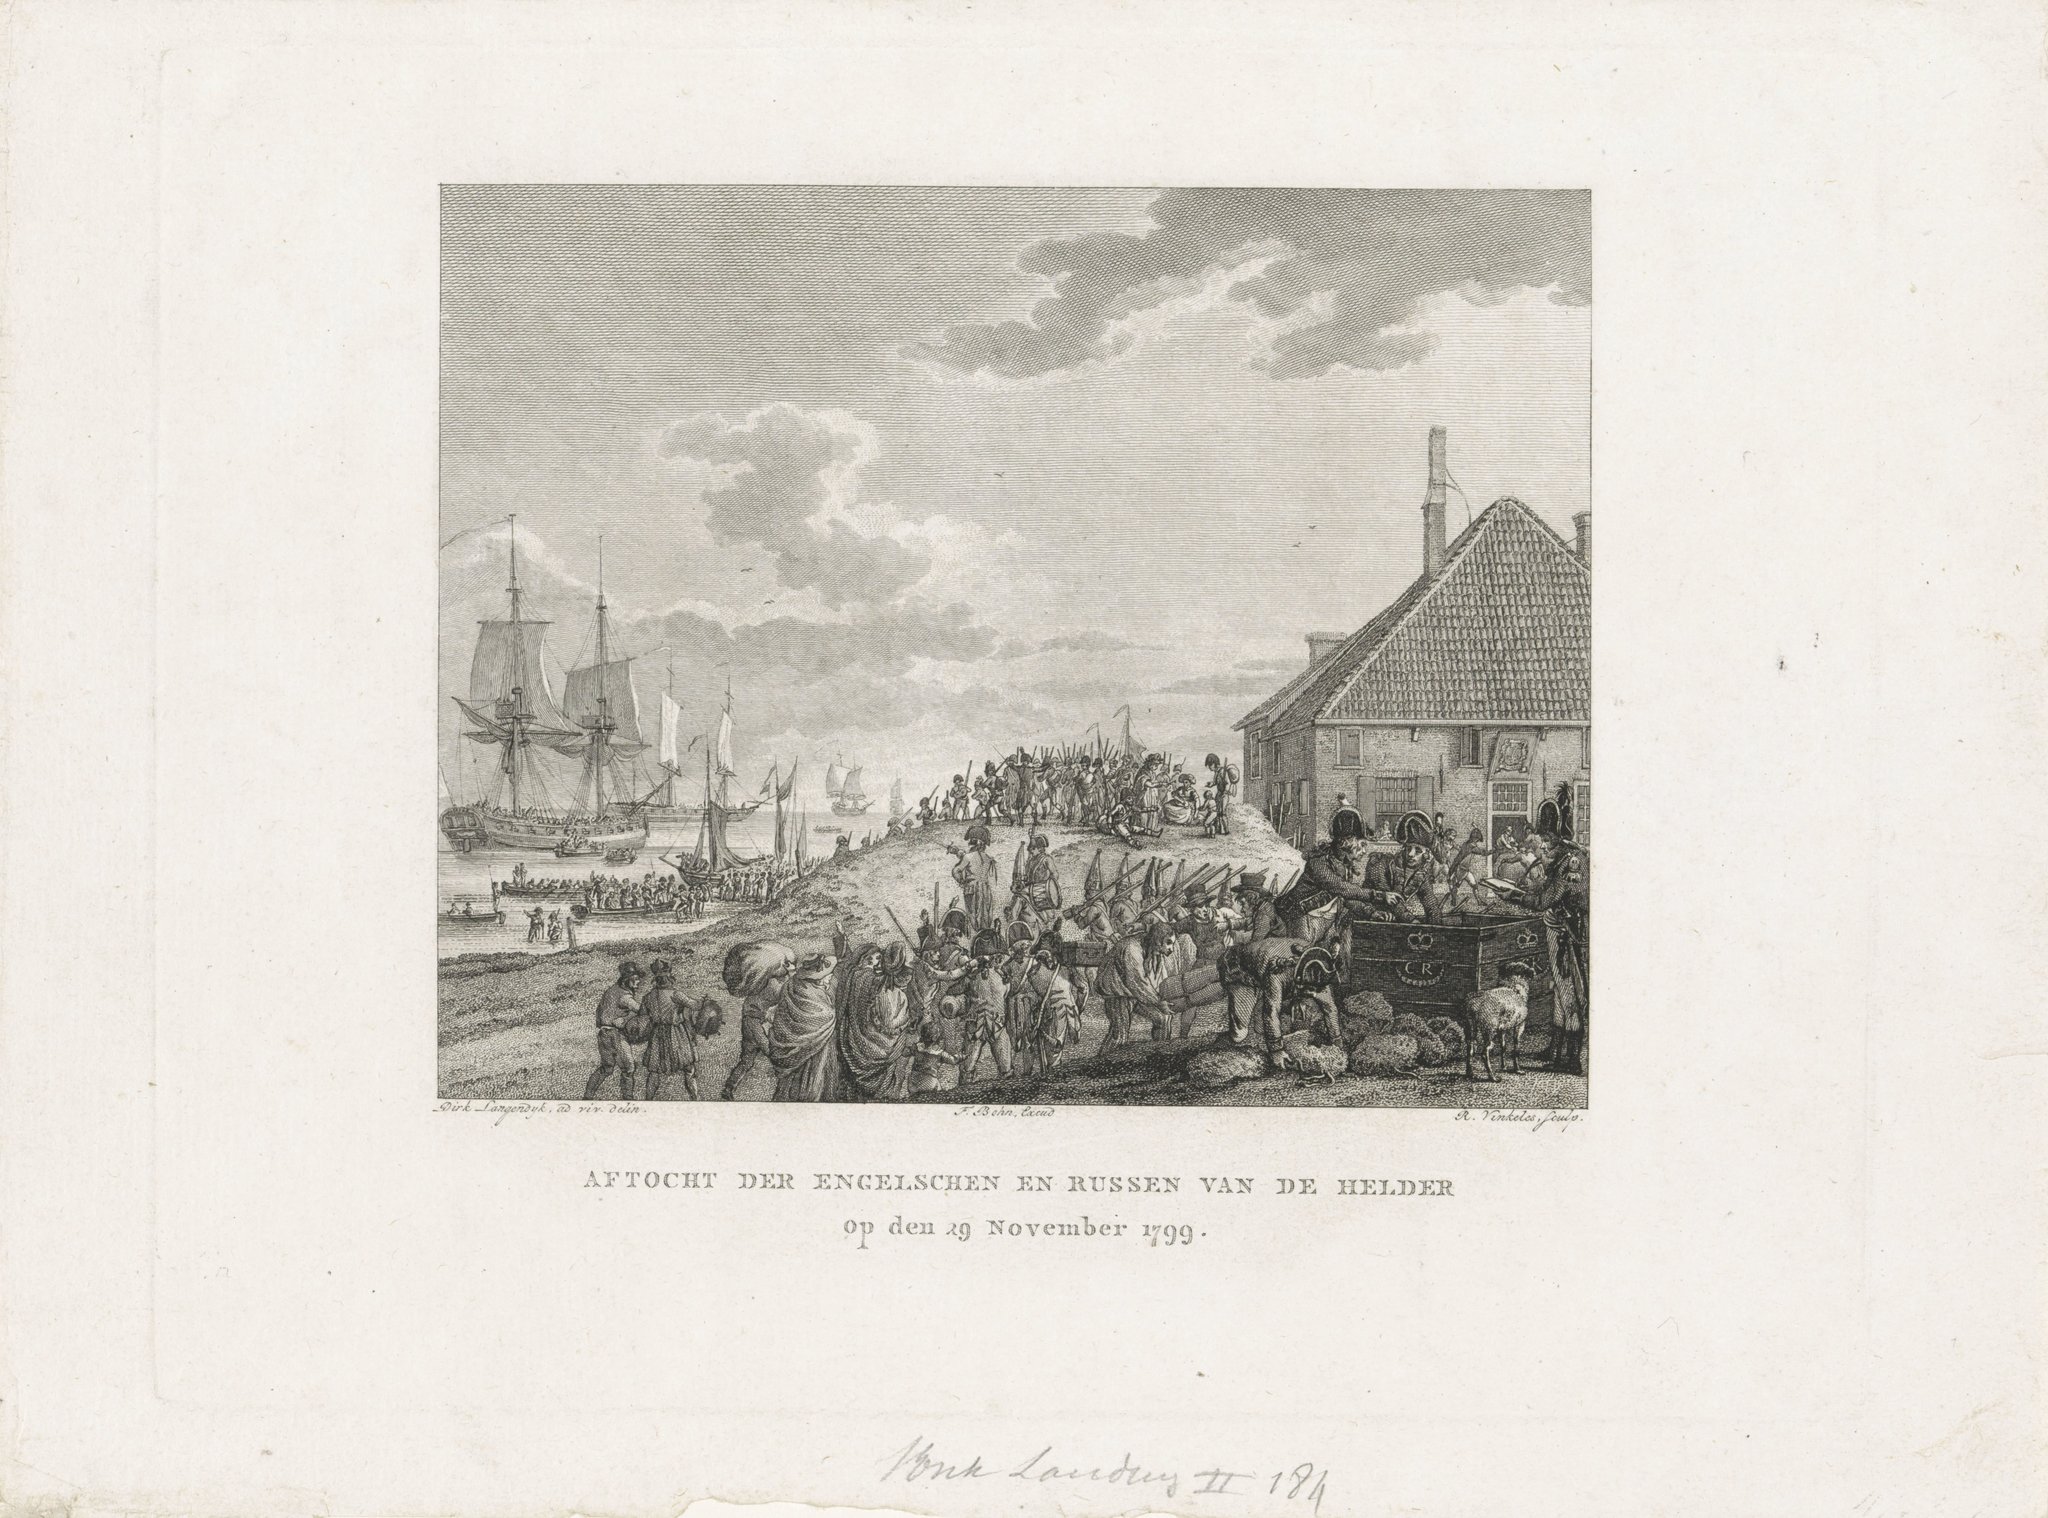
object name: print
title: Aftocht van de Britten en Russen uit Den Helder, 1799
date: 1800-1802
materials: paper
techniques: engraving, etching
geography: den helder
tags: transport, train (military) (+ sailing-ships), den helder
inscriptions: collector's mark: Lugt 2228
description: Gebruikt als illustratie in: L.C. Vonk. Geschiedenis der landing van het Engelsch-Russisch leger in Noord-Holland; alsmede der krijgsbedrijven en politieke gebeurtenissen, zoo aldaar, als in Vriesland en Gelderland, in den jare 1799. Haarlem: François Bohn, 2 dln, 1801-1802.